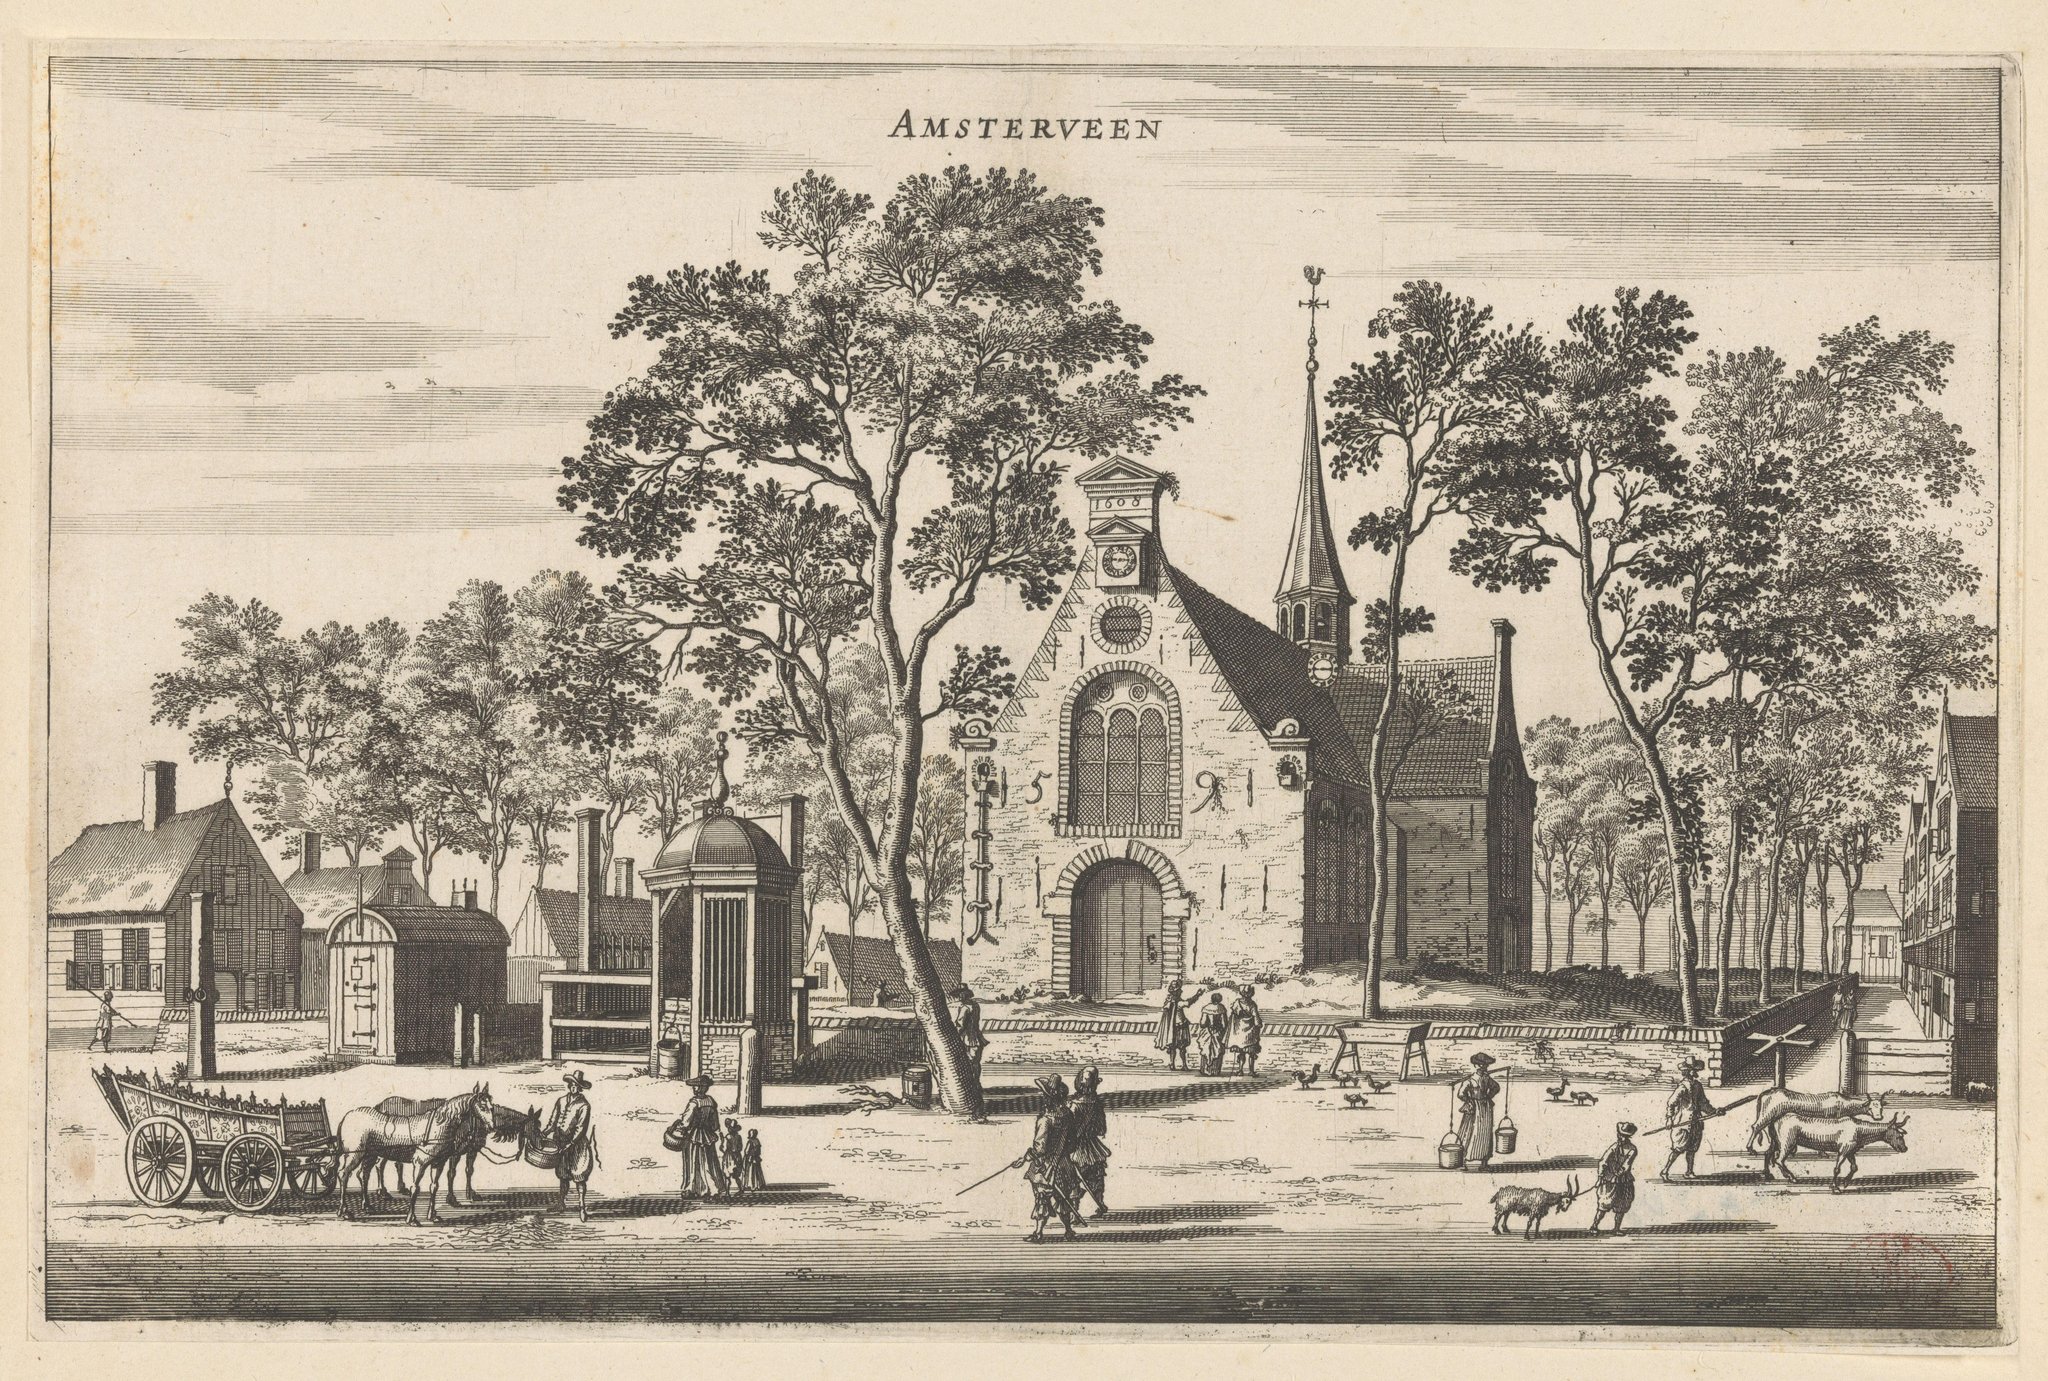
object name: print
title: Gezicht op de kerk te Amstelveen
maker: jacob van meurs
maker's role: draughtsman, print maker, publisher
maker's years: 1619-1680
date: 1663-1664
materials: paper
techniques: engraving, etching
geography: amsterdam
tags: church (exterior), village square, place (+ city(-scape) with figures, staffage)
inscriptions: collector's mark: Lugt 195, collector's mark: Lugt 2233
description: Prent ook gebruikt in: Dapper, Olfert. Historische beschryving der stadt Amsterdam: waer in de voornaemste geschiedenissen (na een kort verhael van gansch Hollant en d'omleggende dorpen (…). Amsterdam: Jacob van Meurs, 1663, tussen p. 38 en 39. En in: Zesen, Philipp von. Beschreibung der Stadt Amsterdam: darinnen von derselben ersten Ursprunge bis auf gegenwärtigen Zustand (…). Amsterdam: Joachim Nosche, 1664.